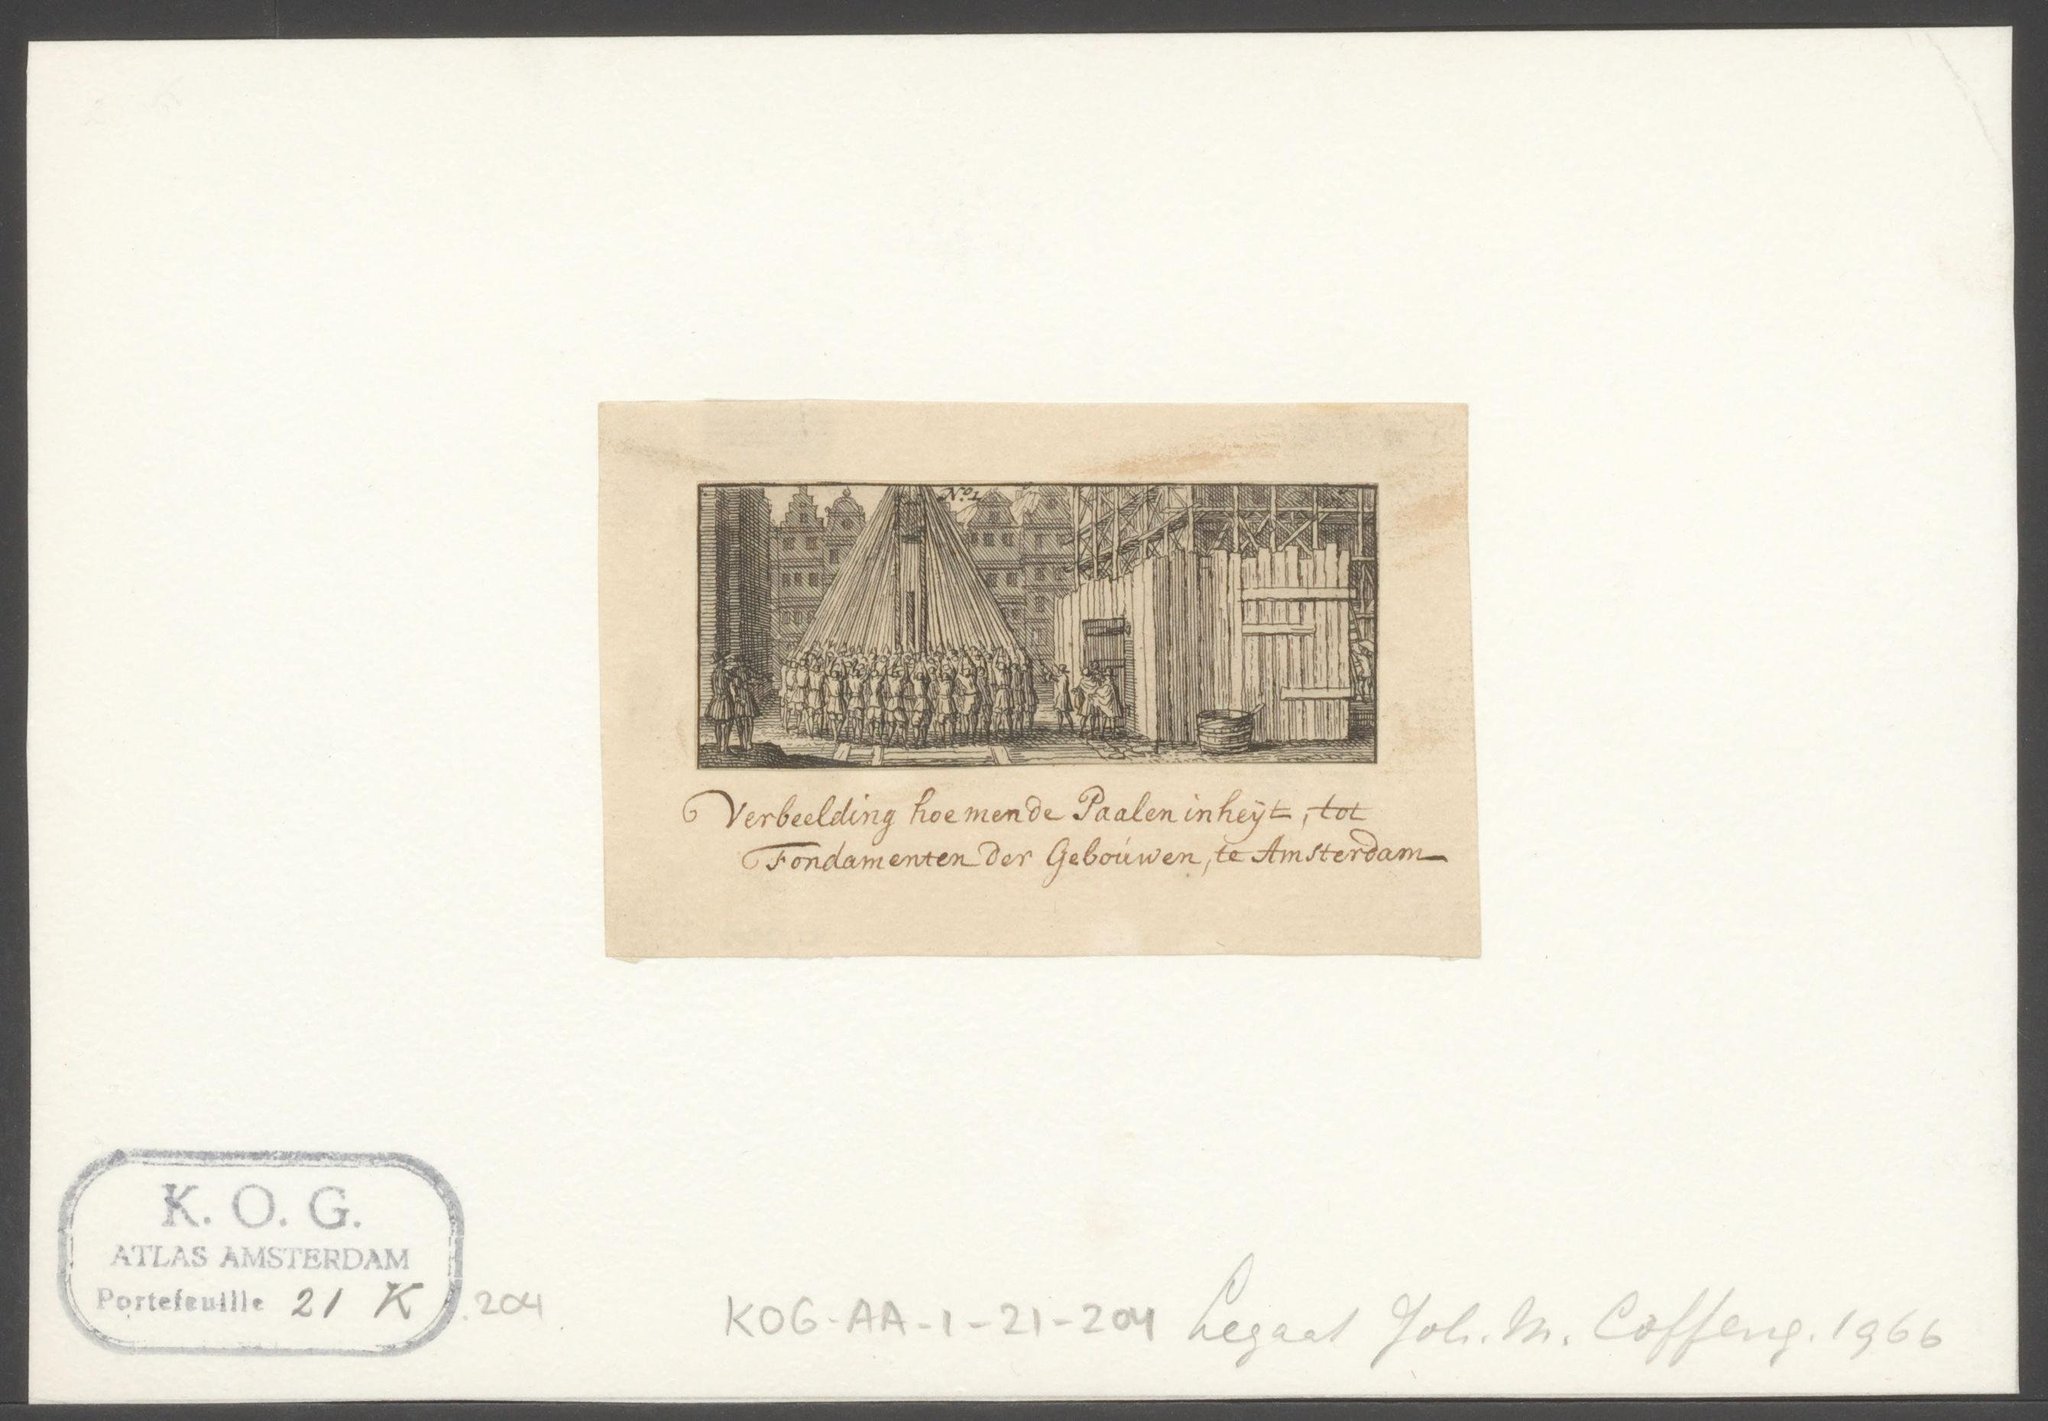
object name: print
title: Heien van palen voor fundament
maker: Anonymous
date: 1580-1700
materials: ink, paper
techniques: etching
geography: northern netherlands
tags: ramming, driving piles (~ building activities), architect supervising building activities, amsterdam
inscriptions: inscription: ‘Legaat Joh. M. Coffeng. 1966’, collector's mark: ‘21K.204’ Lugt 1641b, inscription: ‘Verbeelding hoe men de paalen inheijt, tot fondamenten der gebouwen, te Amsterdam’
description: Onderwerpsrubriek binnen de Atlas Amsterdam: Opgravingen.